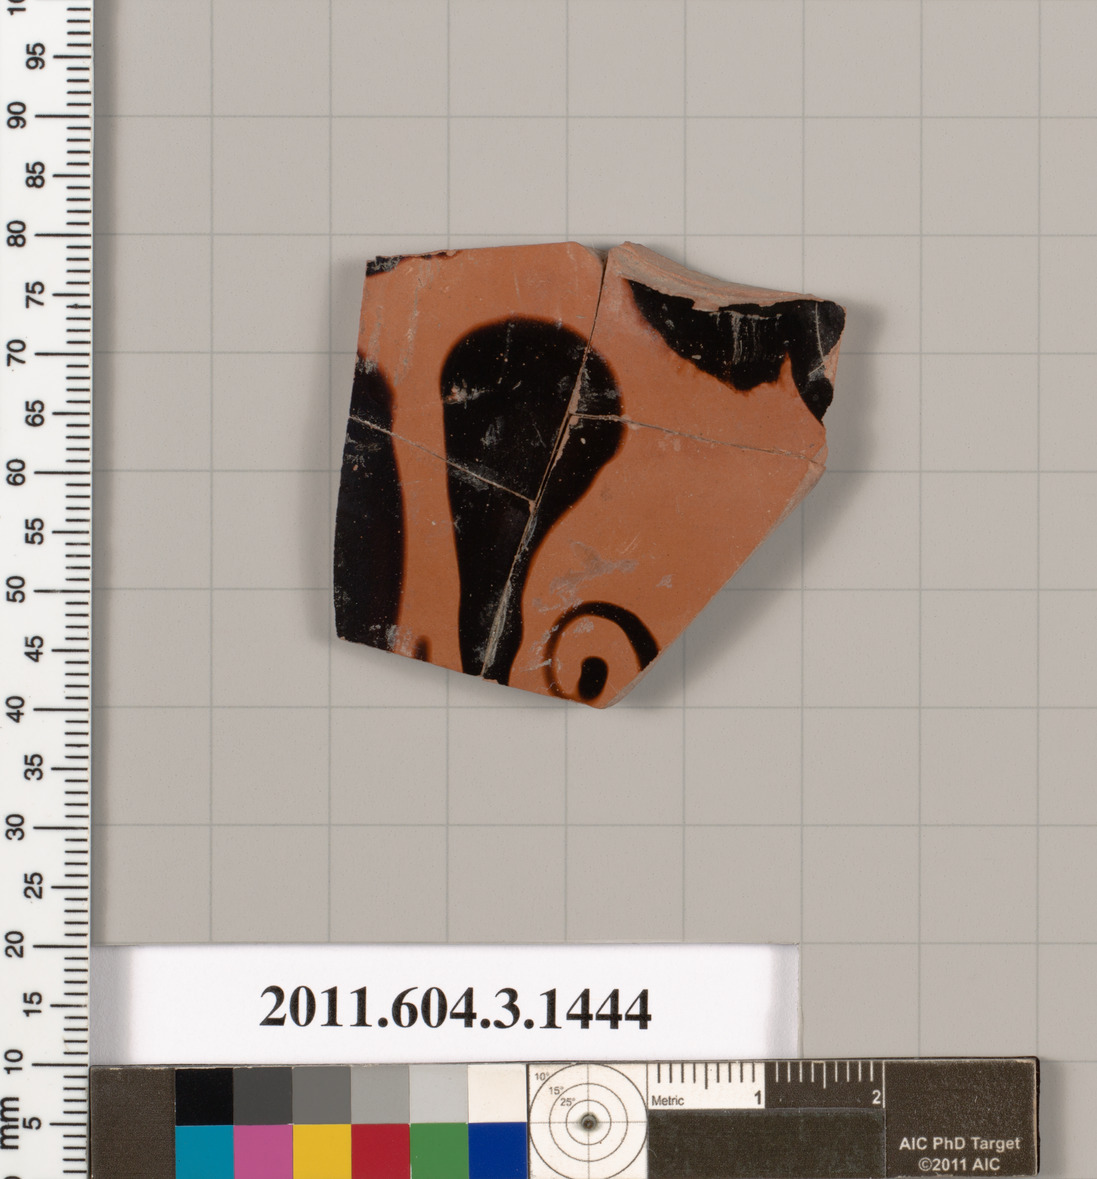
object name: skyphos fragment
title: Terracotta fragment of a skyphos (deep drinking cup)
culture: greek, attic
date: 534-468 BCE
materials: terracotta